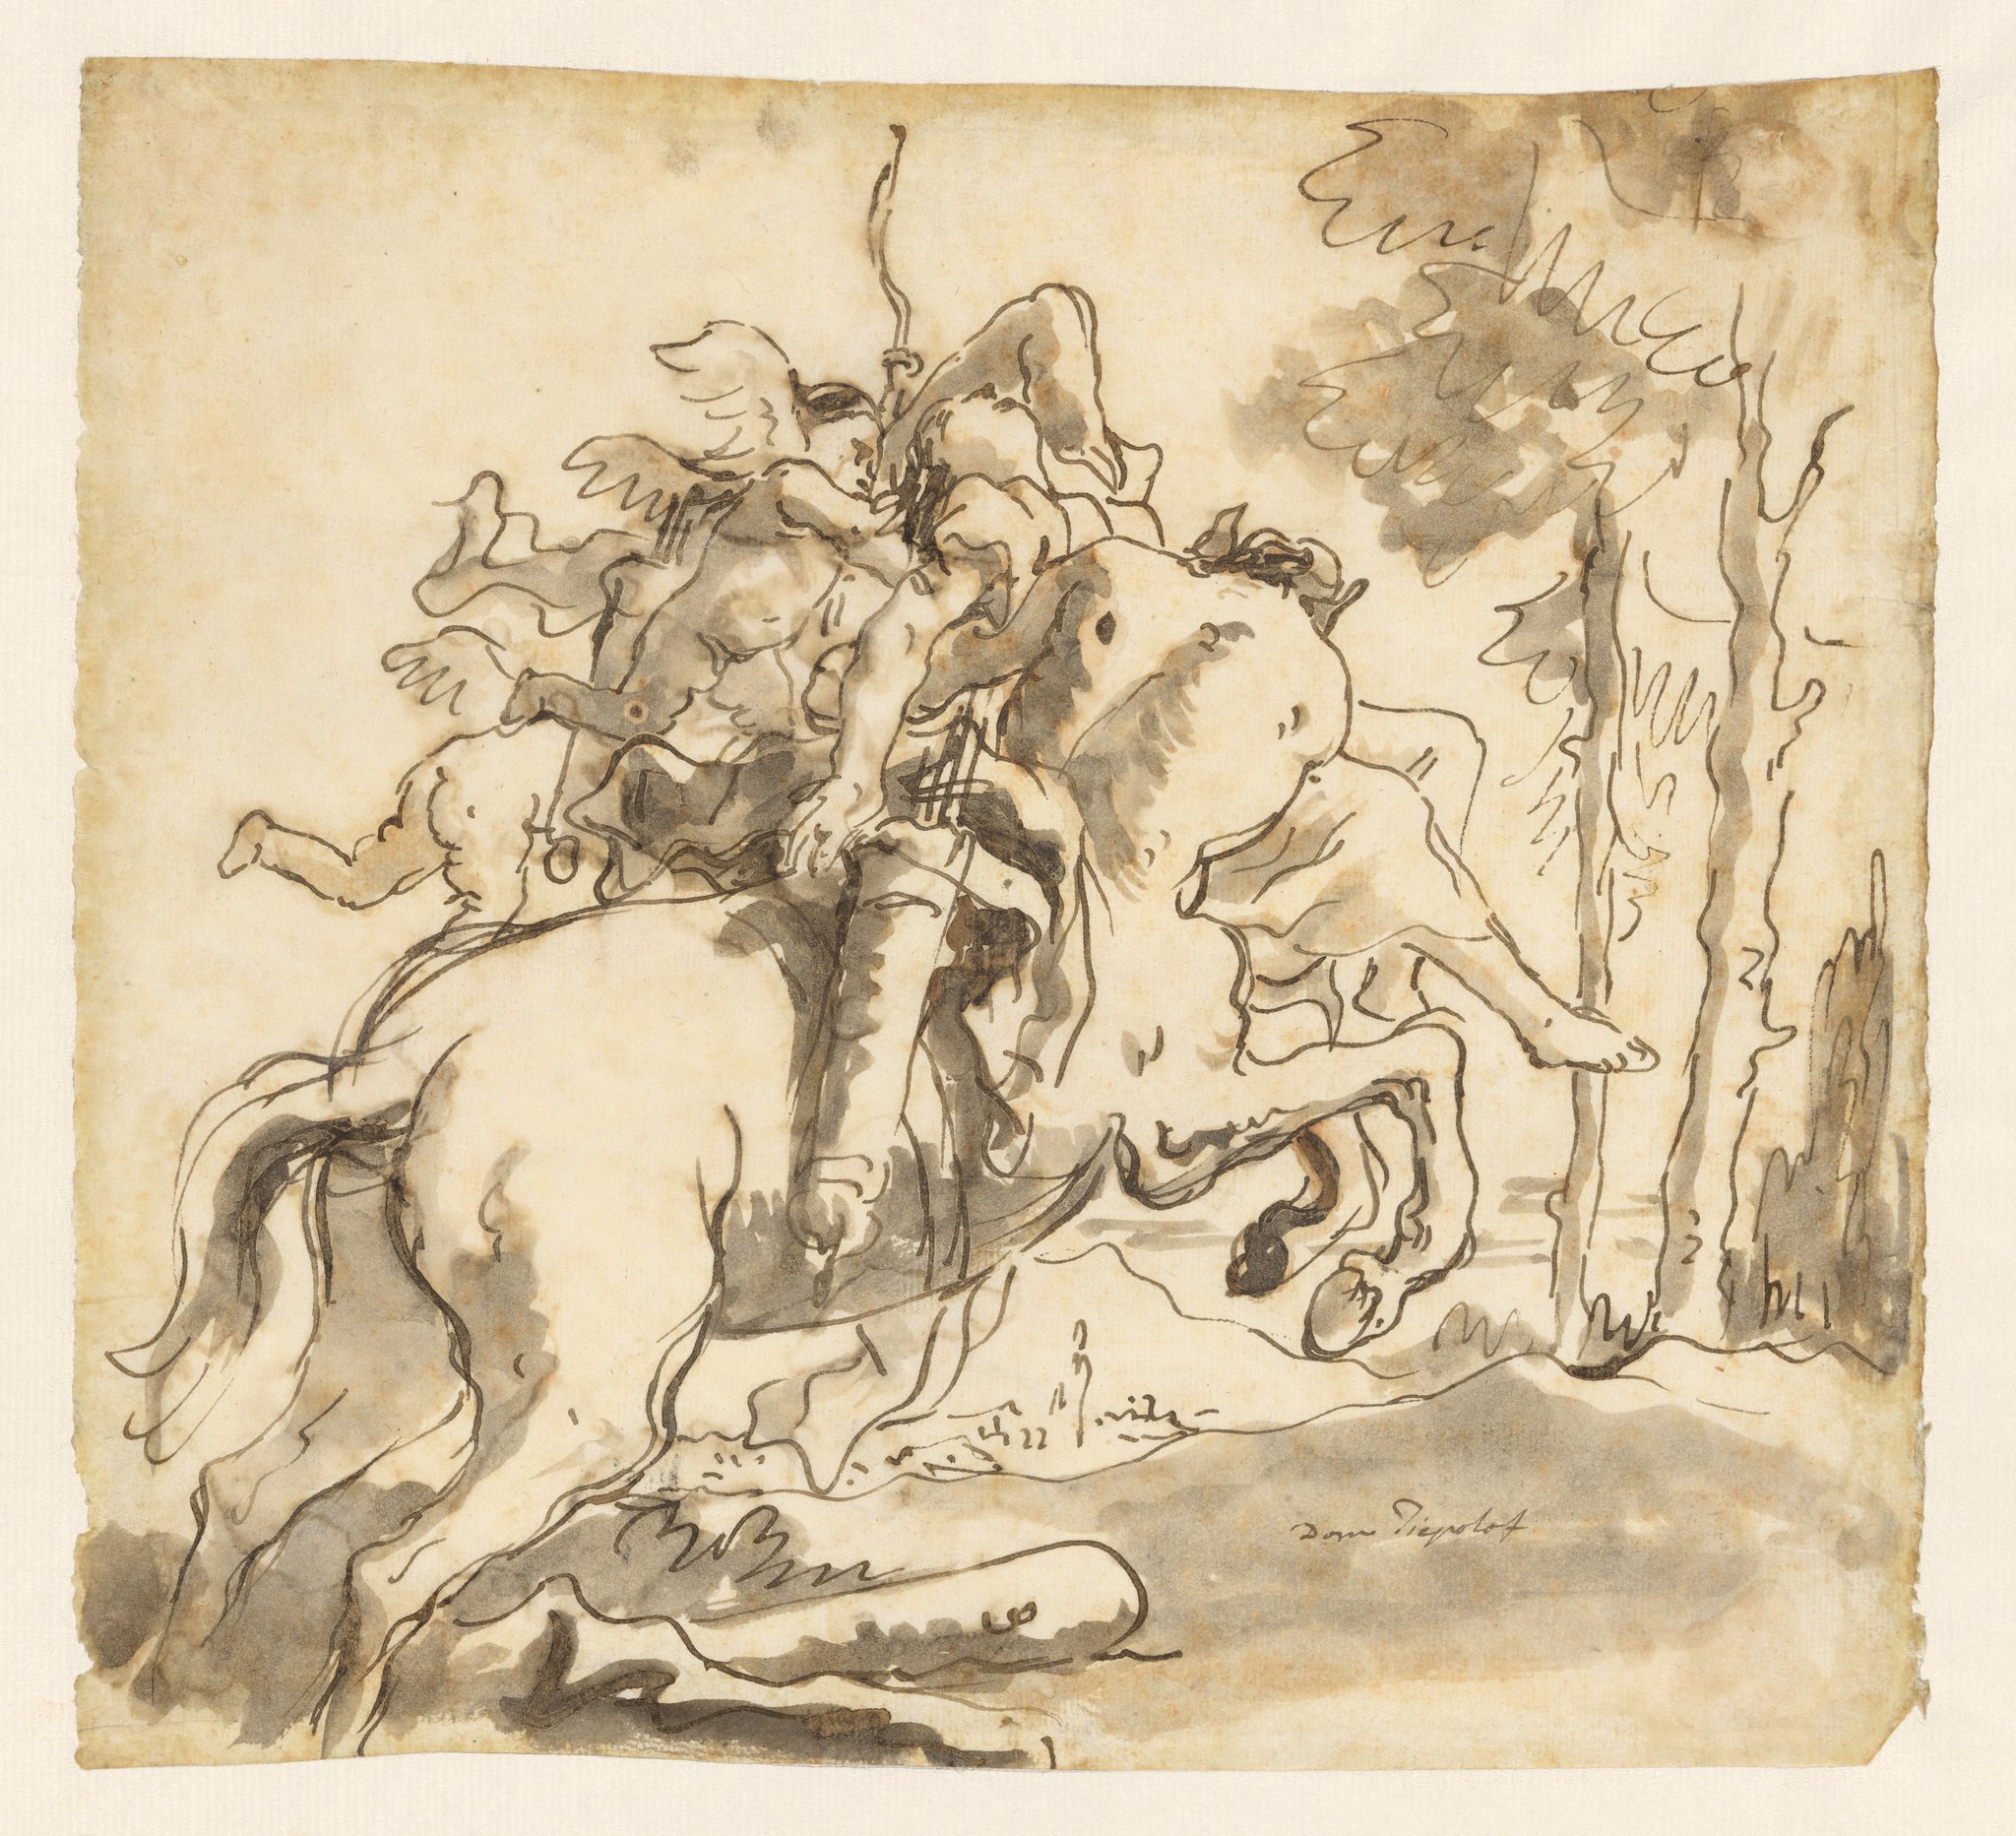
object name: drawing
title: Centaur Carrying Off a Nymph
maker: giovanni domenico tiepolo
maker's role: artist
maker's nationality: italian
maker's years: 1727-1804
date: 1734-1800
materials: ink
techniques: pen, wash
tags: centaurs,nymphs